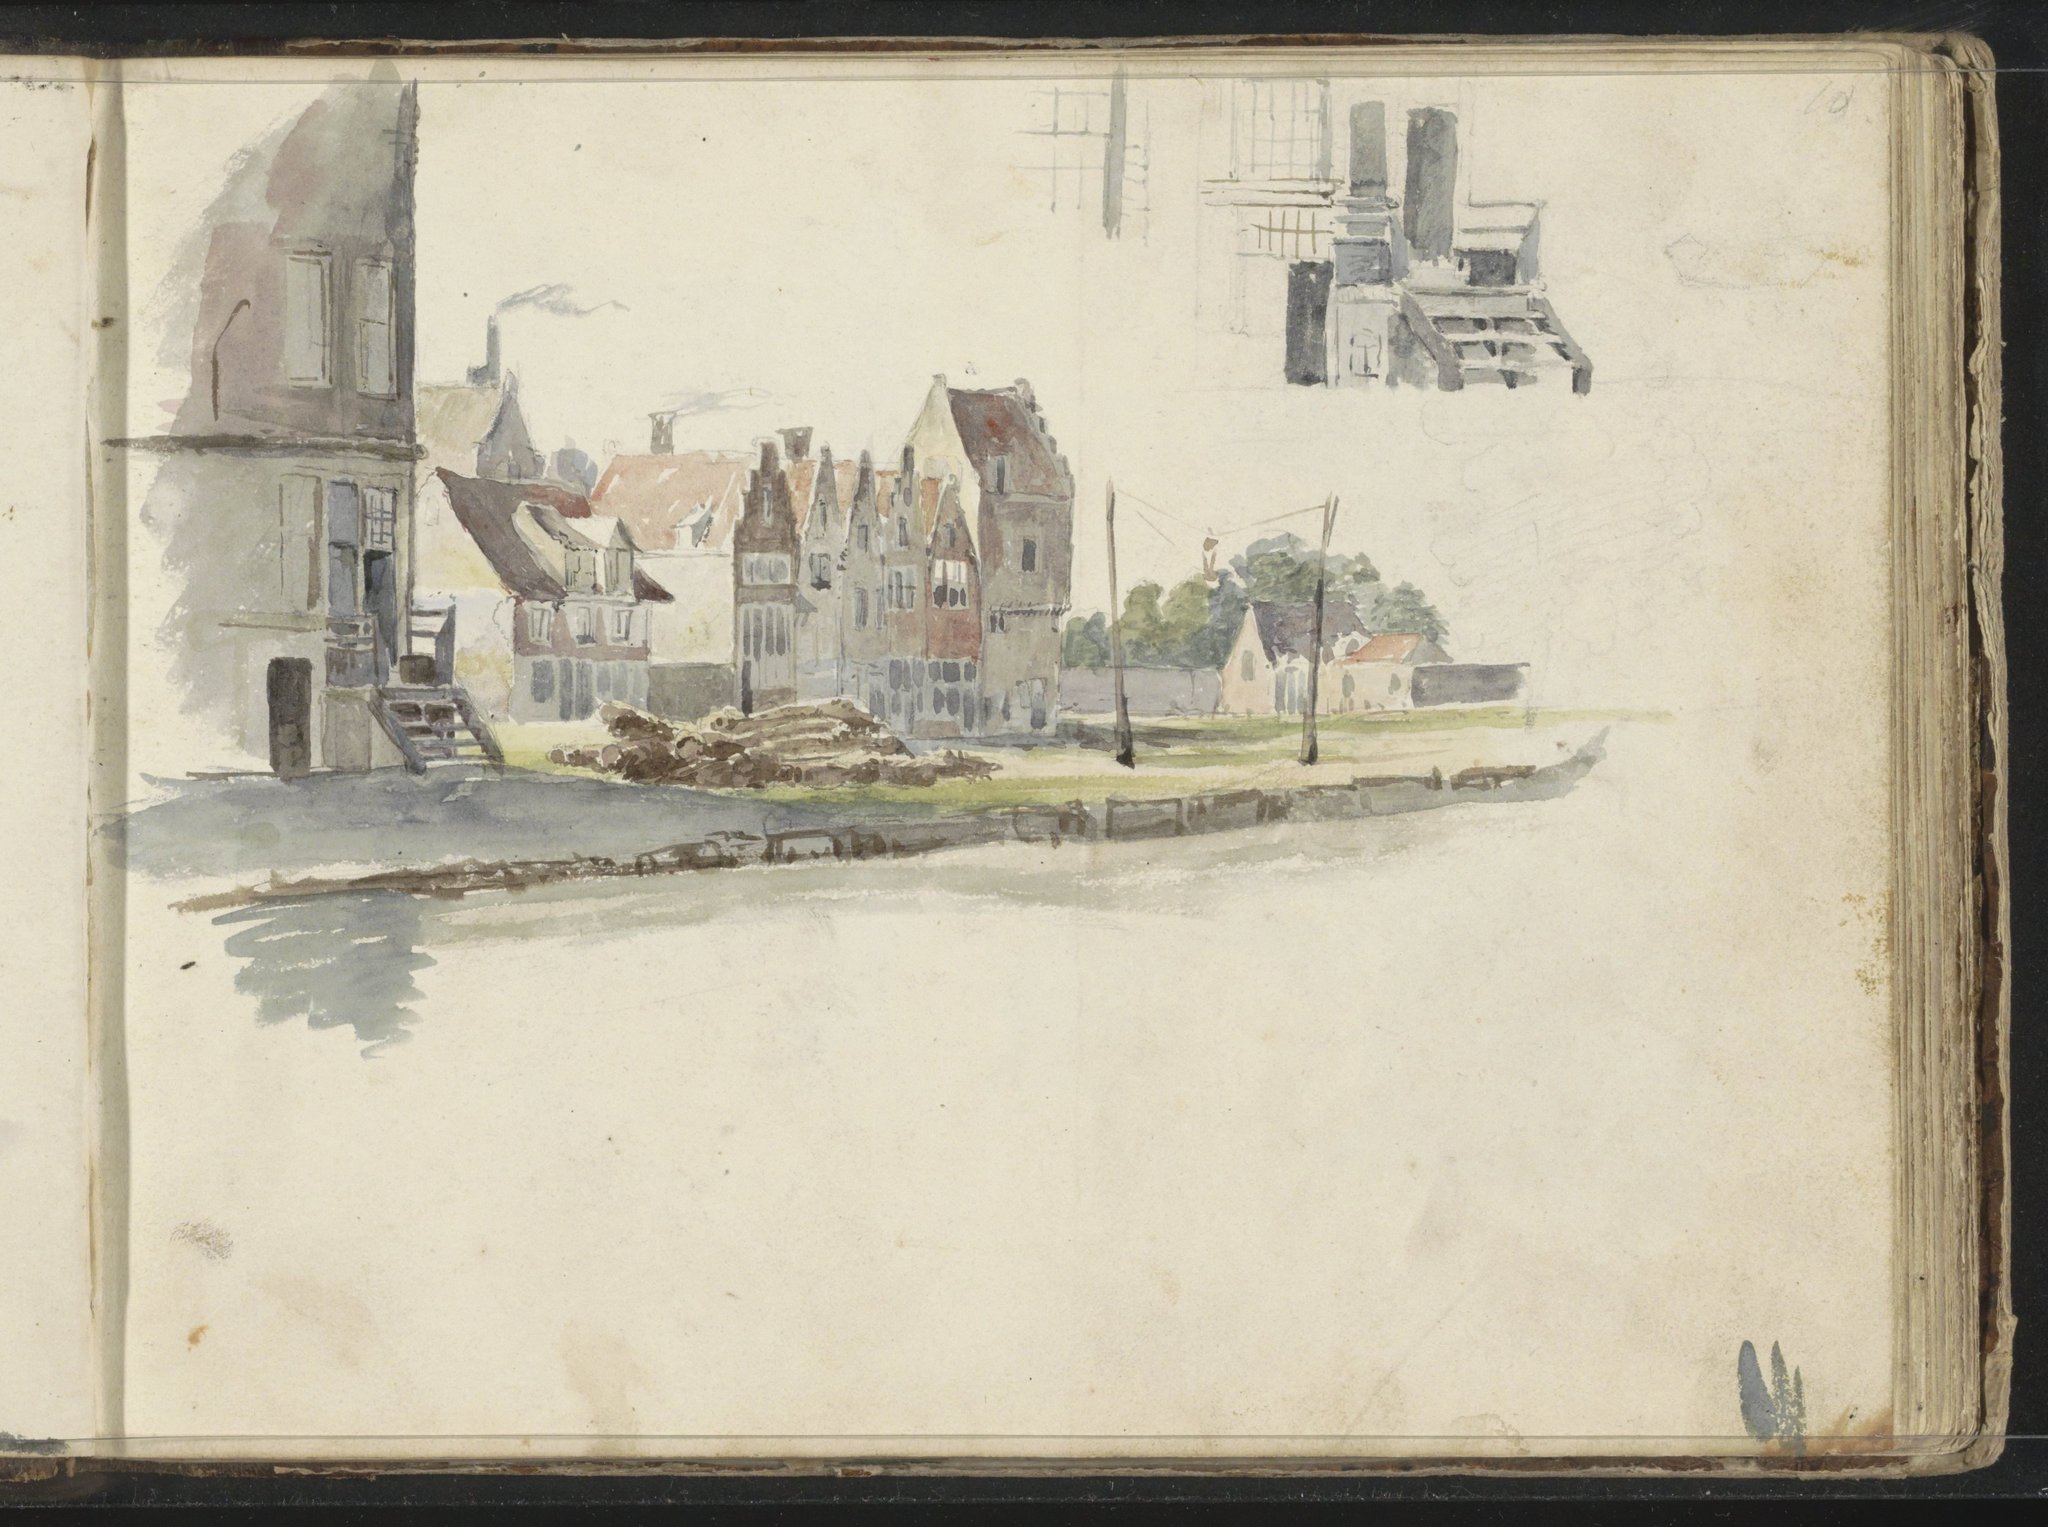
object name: sketchbook leaf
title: Pakhuizen aan een kade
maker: willem troost (ii)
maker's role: draughtsman, painter, print maker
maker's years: 1812-1893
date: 1822-1893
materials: paper, pencil, watercolor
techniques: brush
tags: flight of steps, canals, waters (in city), the usual house or row of houses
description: Tevens een studie van een trap aan de achterzijde van een huis. Blad 10 recto uit een schetsboek met 36 bladen.